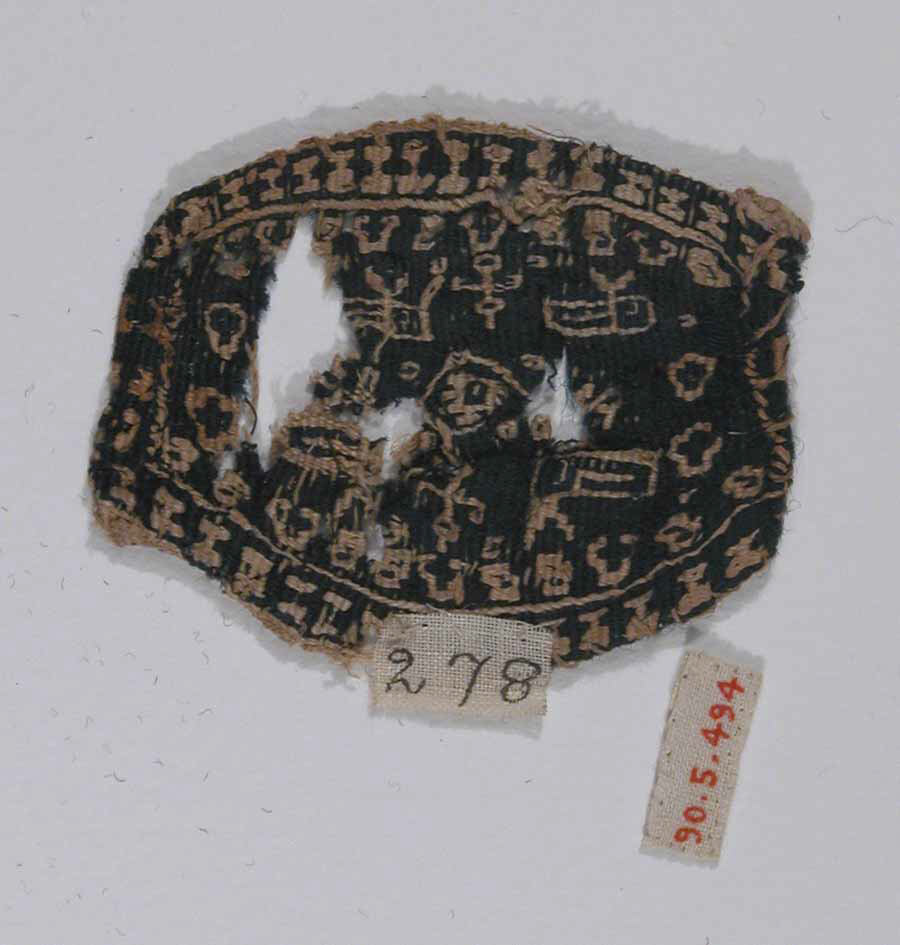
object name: textile fragment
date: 301-500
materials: linen, wool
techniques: weave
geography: egypt